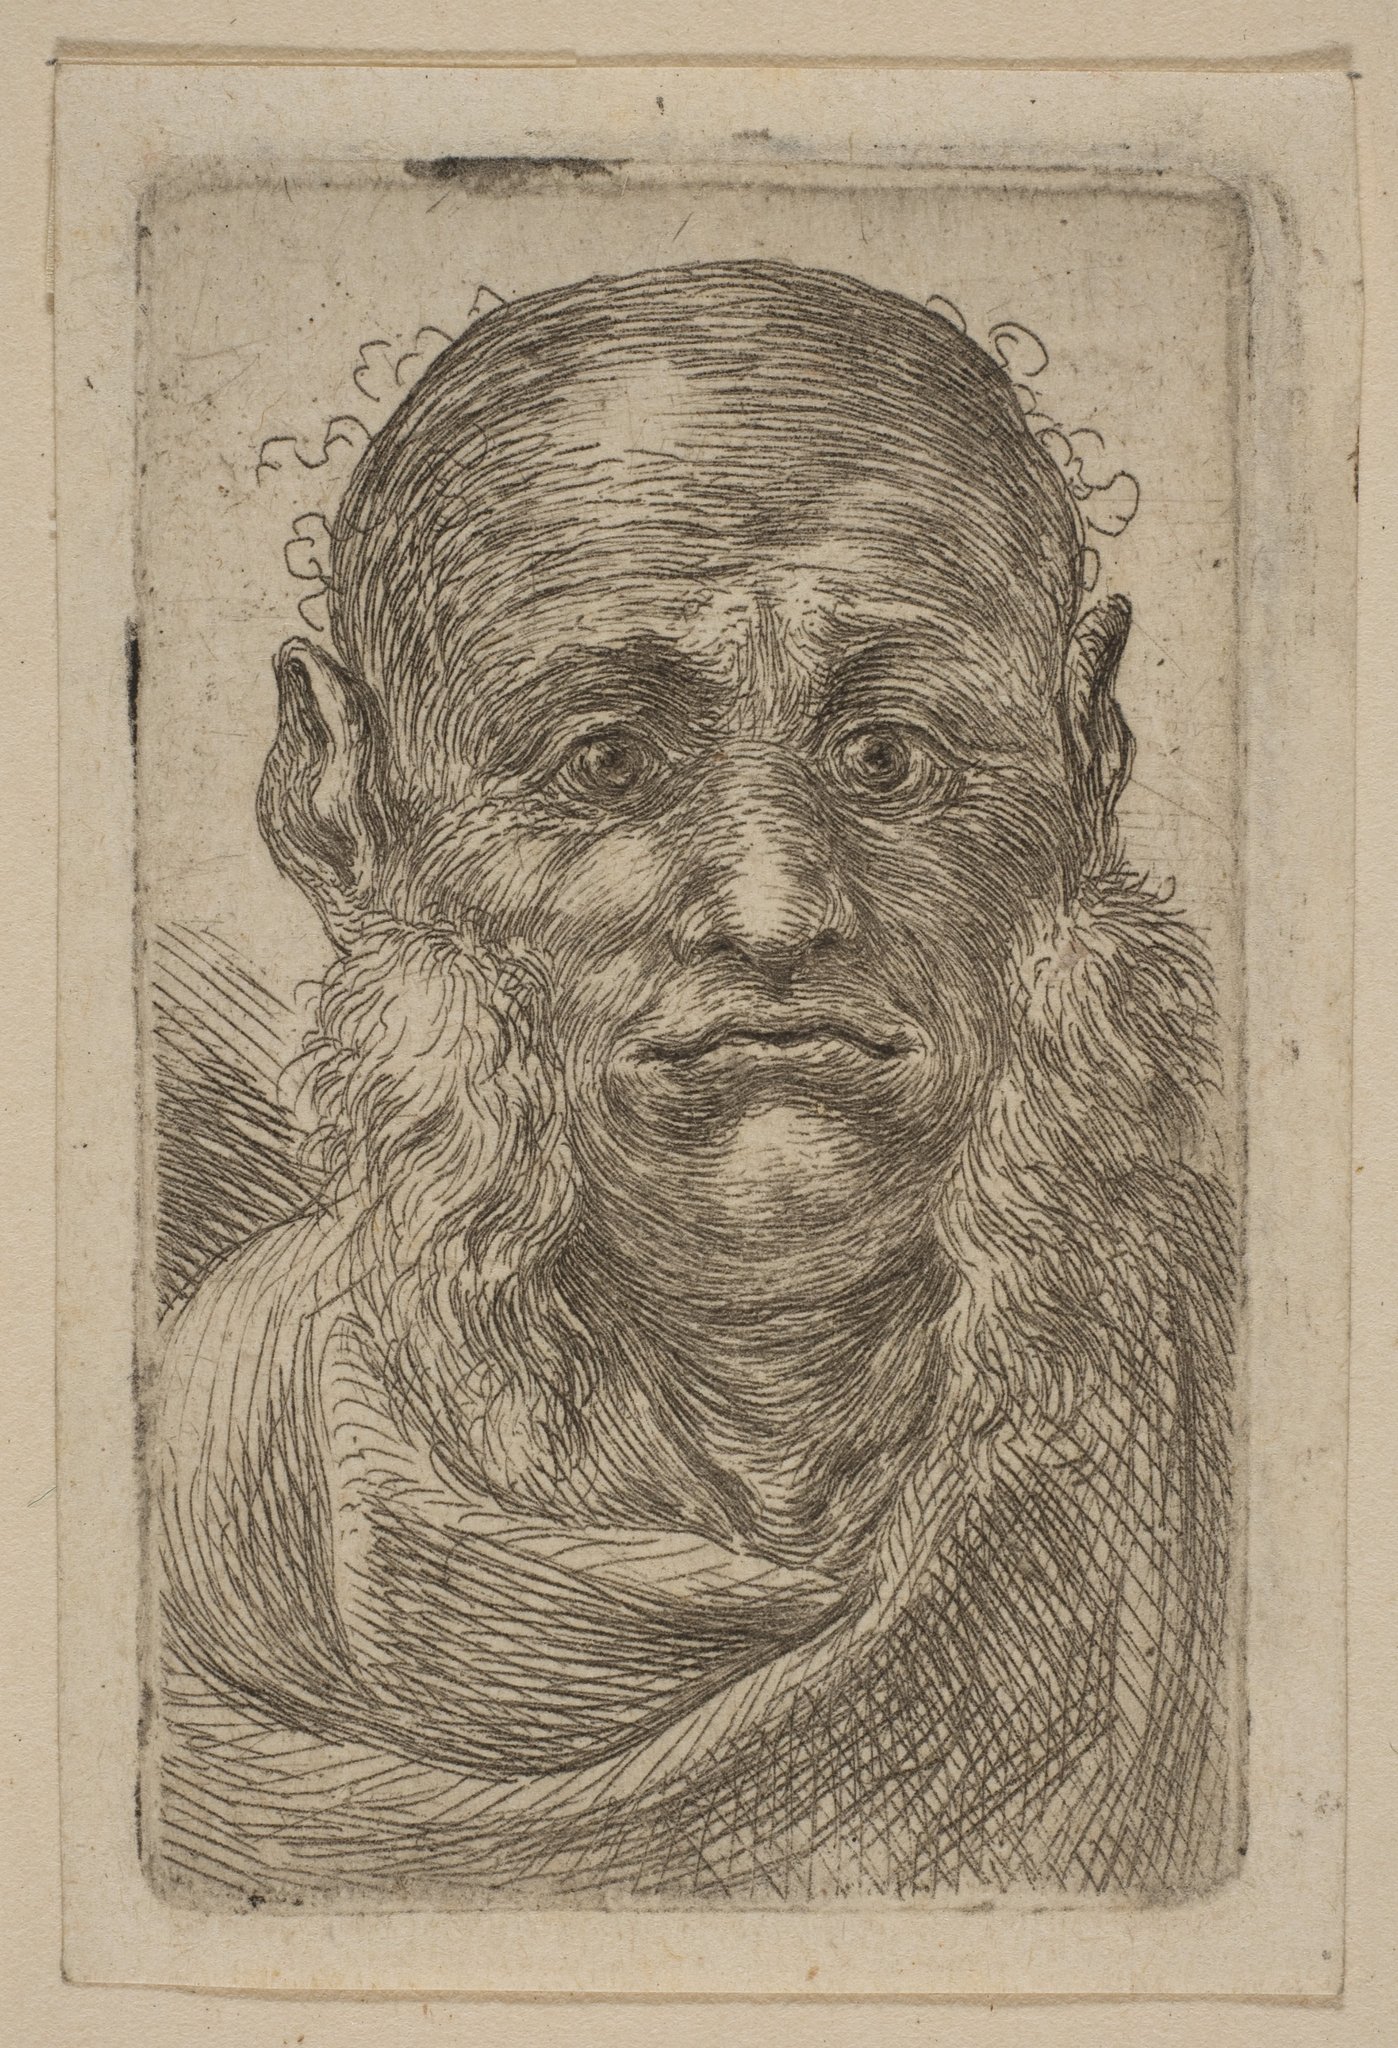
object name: print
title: Head of Old Man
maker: stefano della bella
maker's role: artist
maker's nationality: italian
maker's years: 1610-1664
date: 1610-1664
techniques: etching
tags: heads,portraits